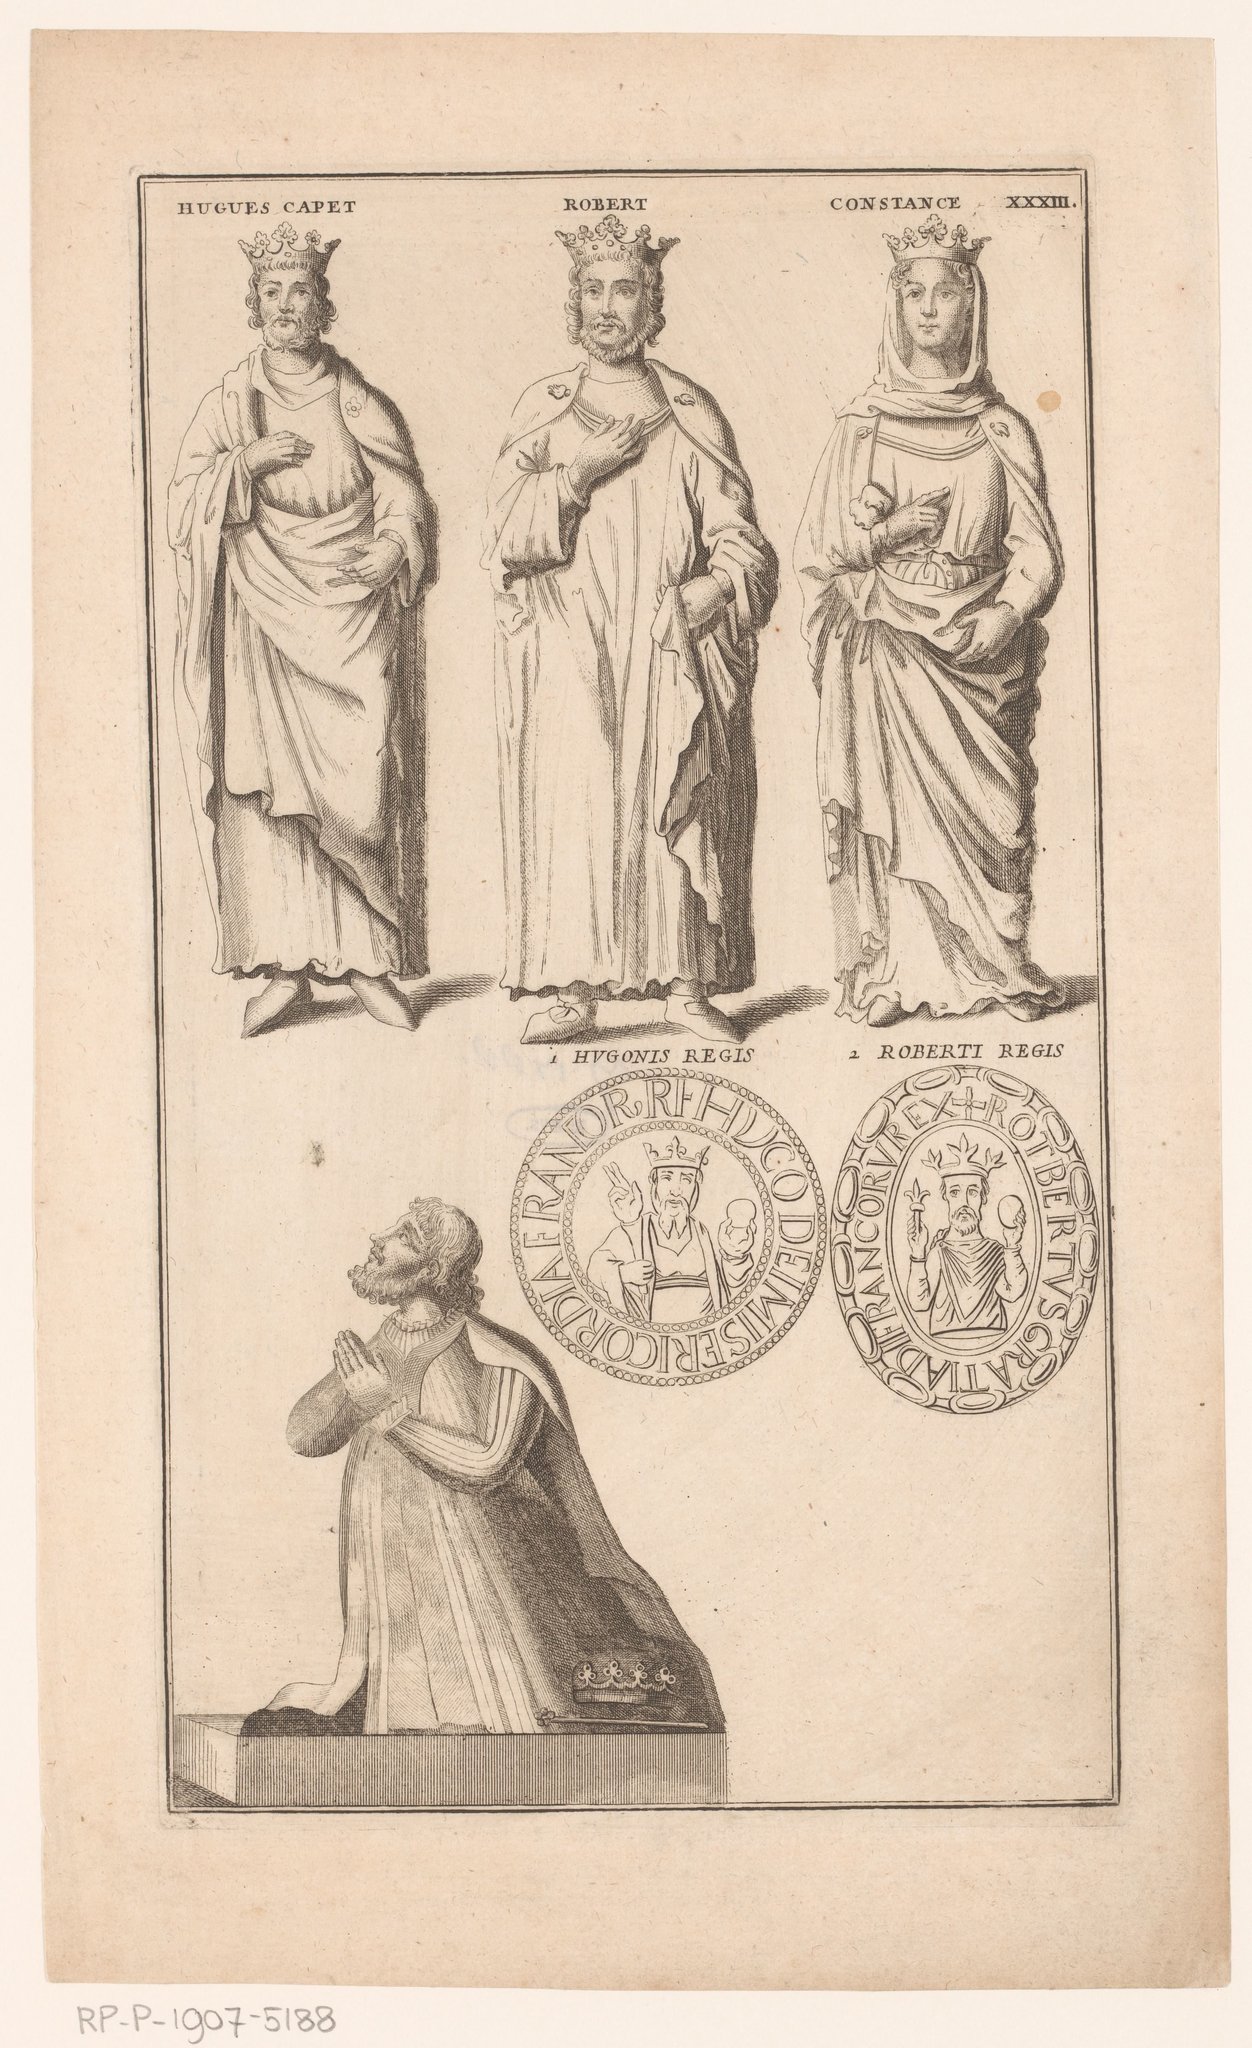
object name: print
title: Diverse portretten van koninklijke figuren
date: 1729-1733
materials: paper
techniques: engraving, etching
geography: paris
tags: historical persons, king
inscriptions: collector's mark: Lugt 2228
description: Prent uit: Montfaucon, Bernard de. Les monumens de la monarchie françoise, qui comprennent l'histoire de France avec les figures de chaque règne que l'injure des tems a épargnées (...). Parijs: Julien-Michel Gandouin en Pierre-François Giffart, 1729-1733, dl. 1, afb. voor p. 371.